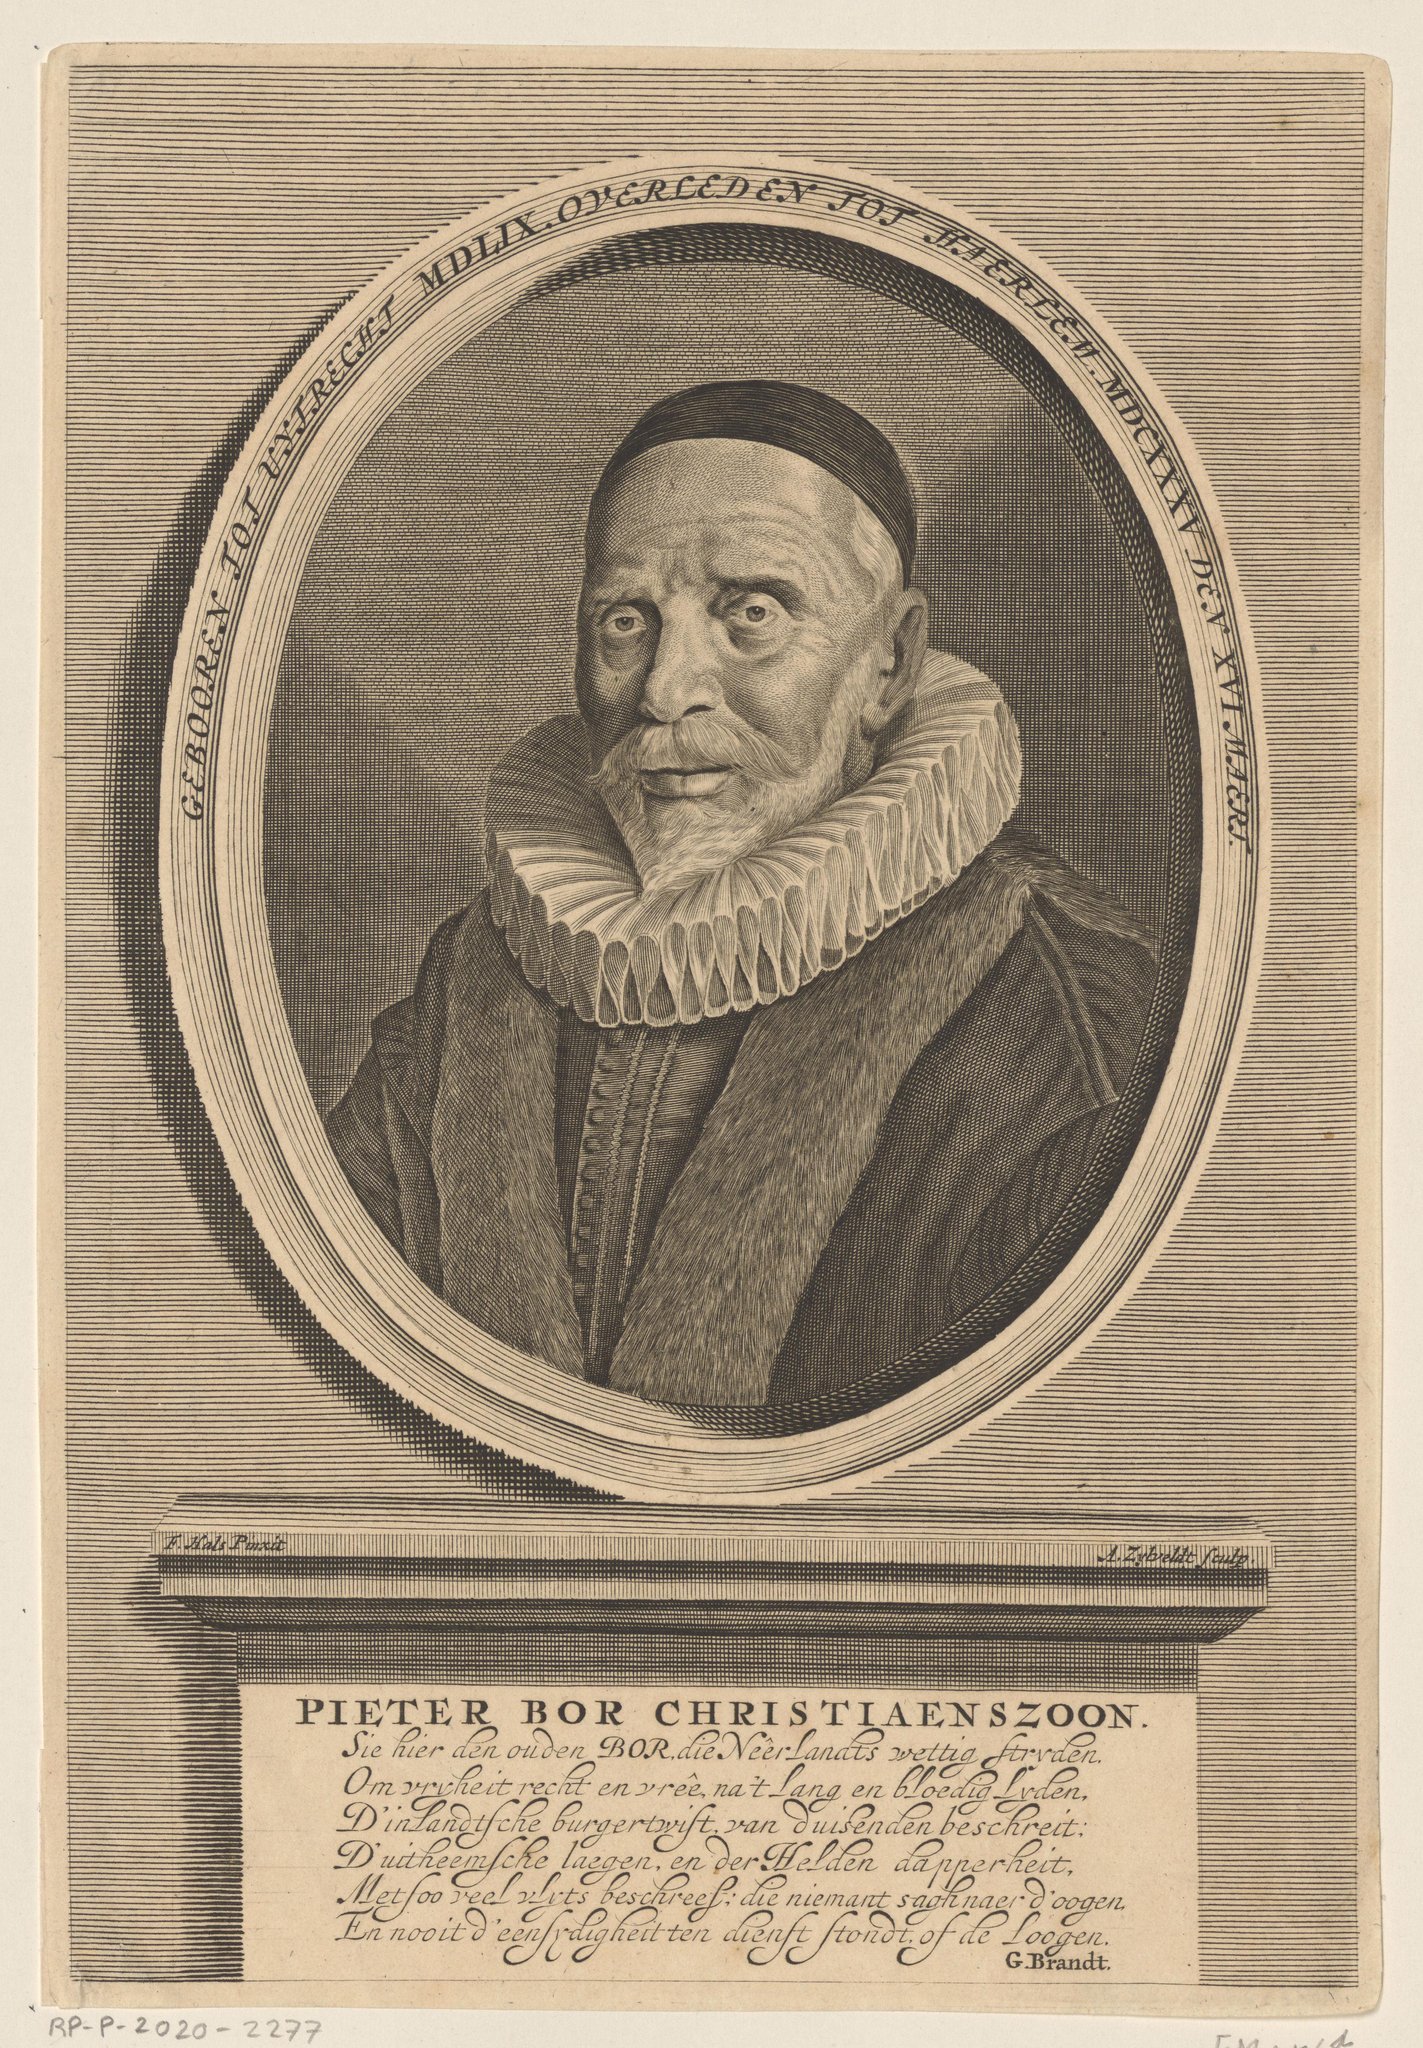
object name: print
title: Portret van Pieter Christiaansz. Bor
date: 1650-1695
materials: paper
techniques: engraving, etching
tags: utrecht, haarlem, historical persons, portrait of a writer